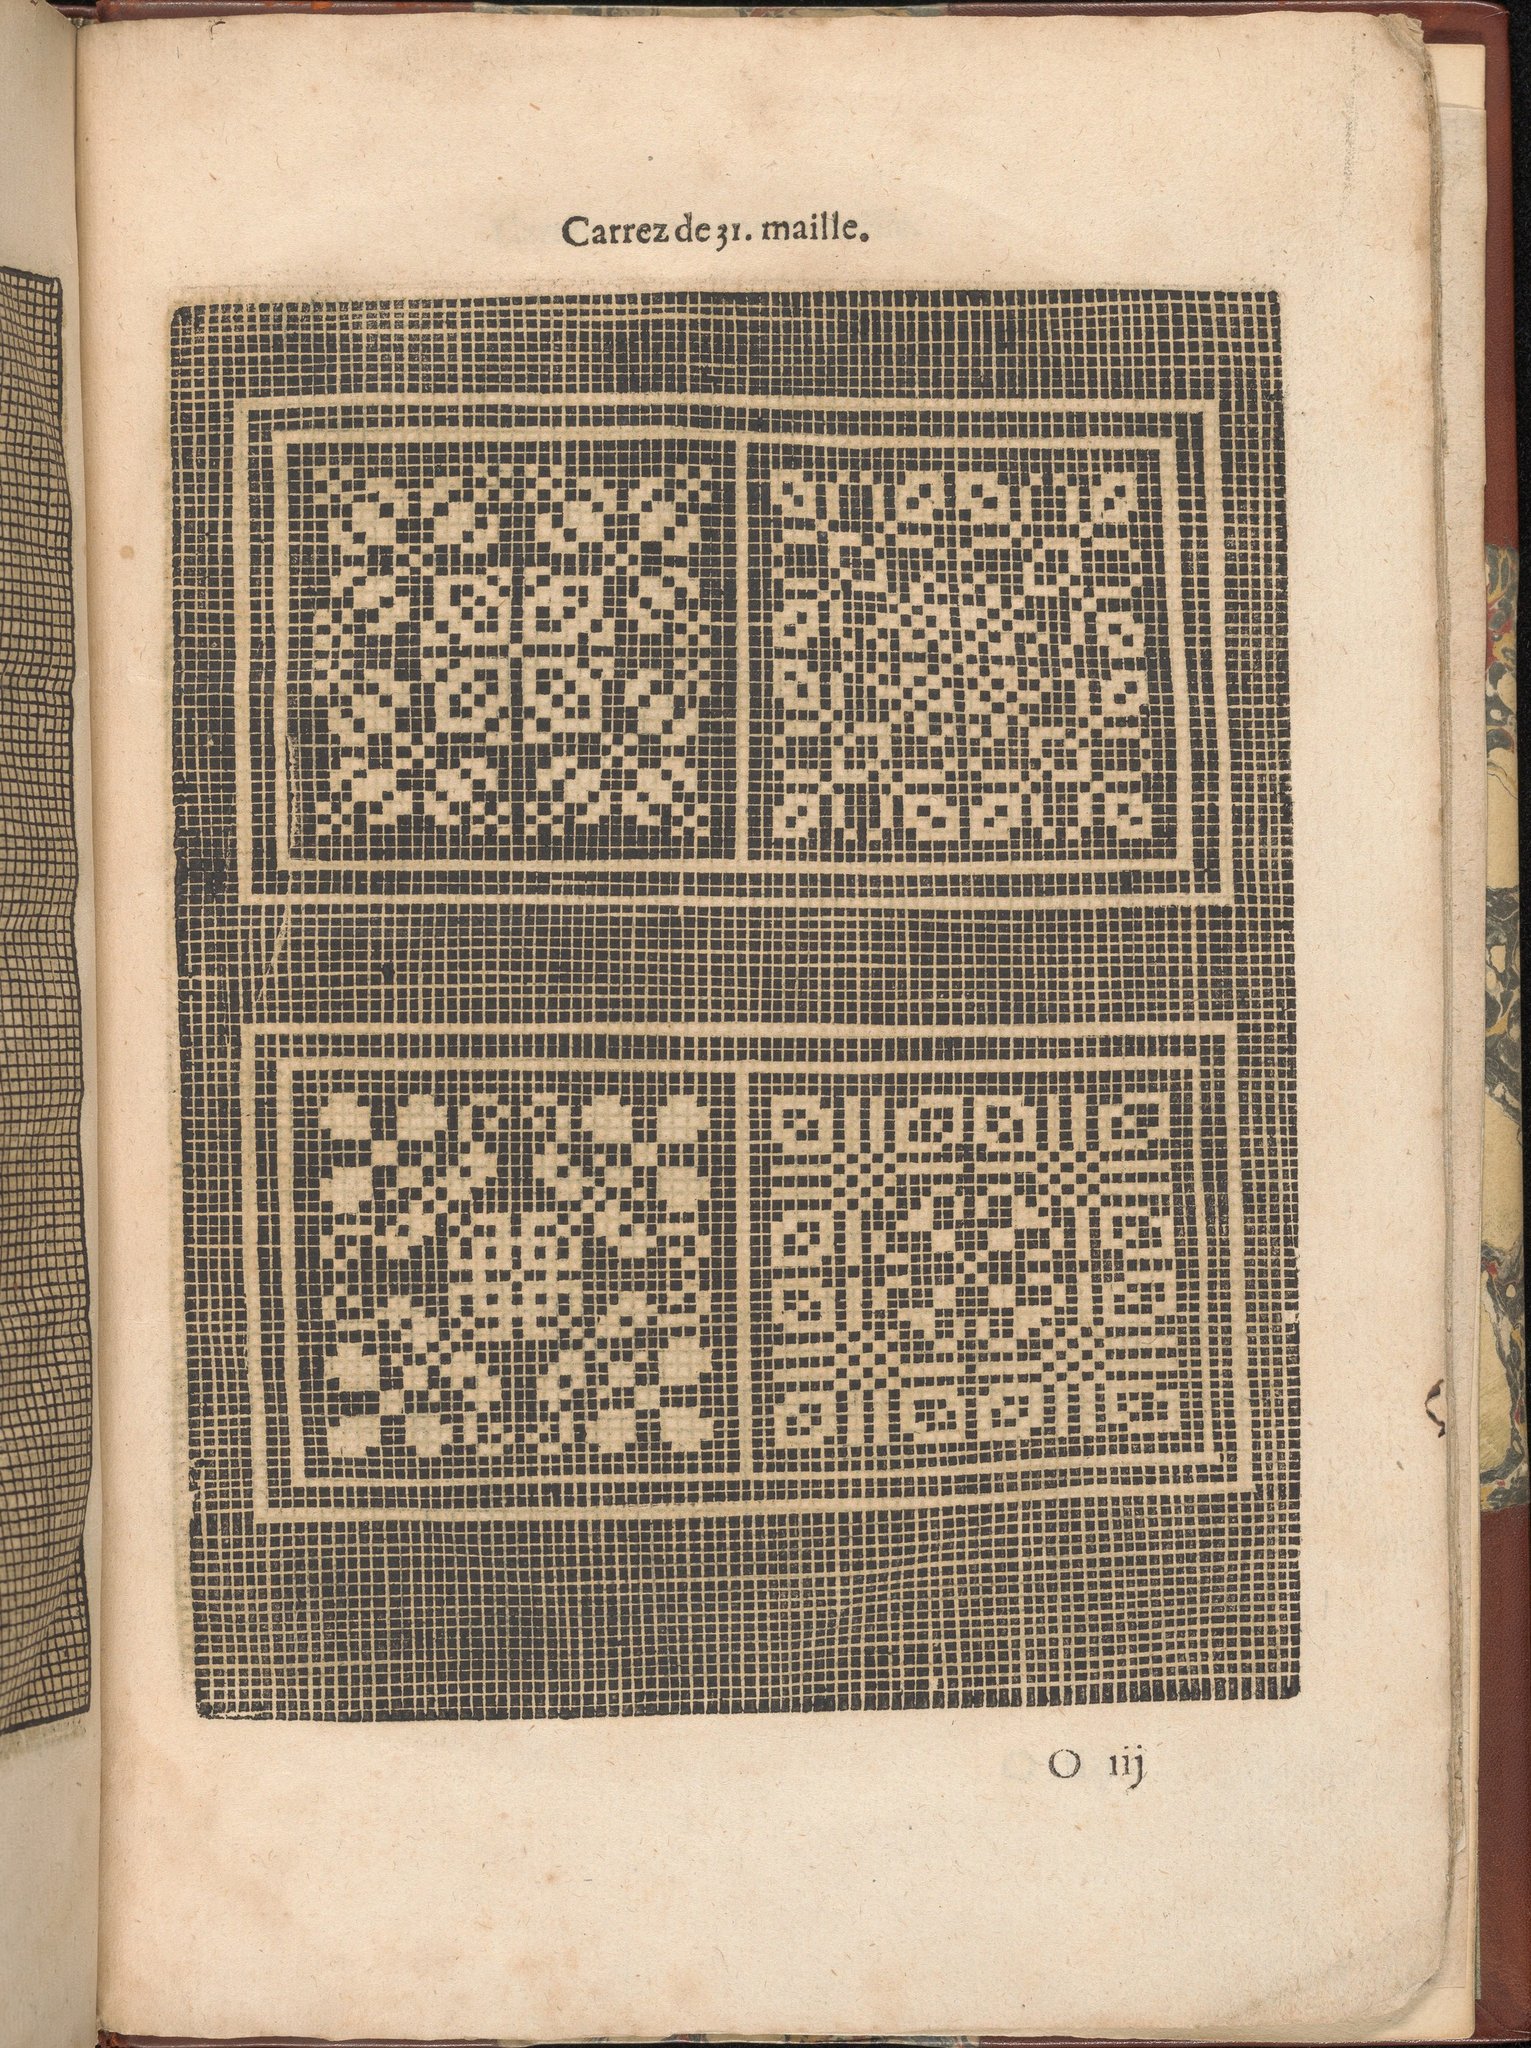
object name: book print ornament architecture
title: Les Secondes Oeuvres, et Subtiles Inventions De Lingerie du Seigneur Federic de Vinciolo Venitien, page 55 (recto)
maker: federico de vinciolo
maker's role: designer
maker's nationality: italian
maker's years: 1582-1599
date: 1603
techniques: woodcut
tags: ornament